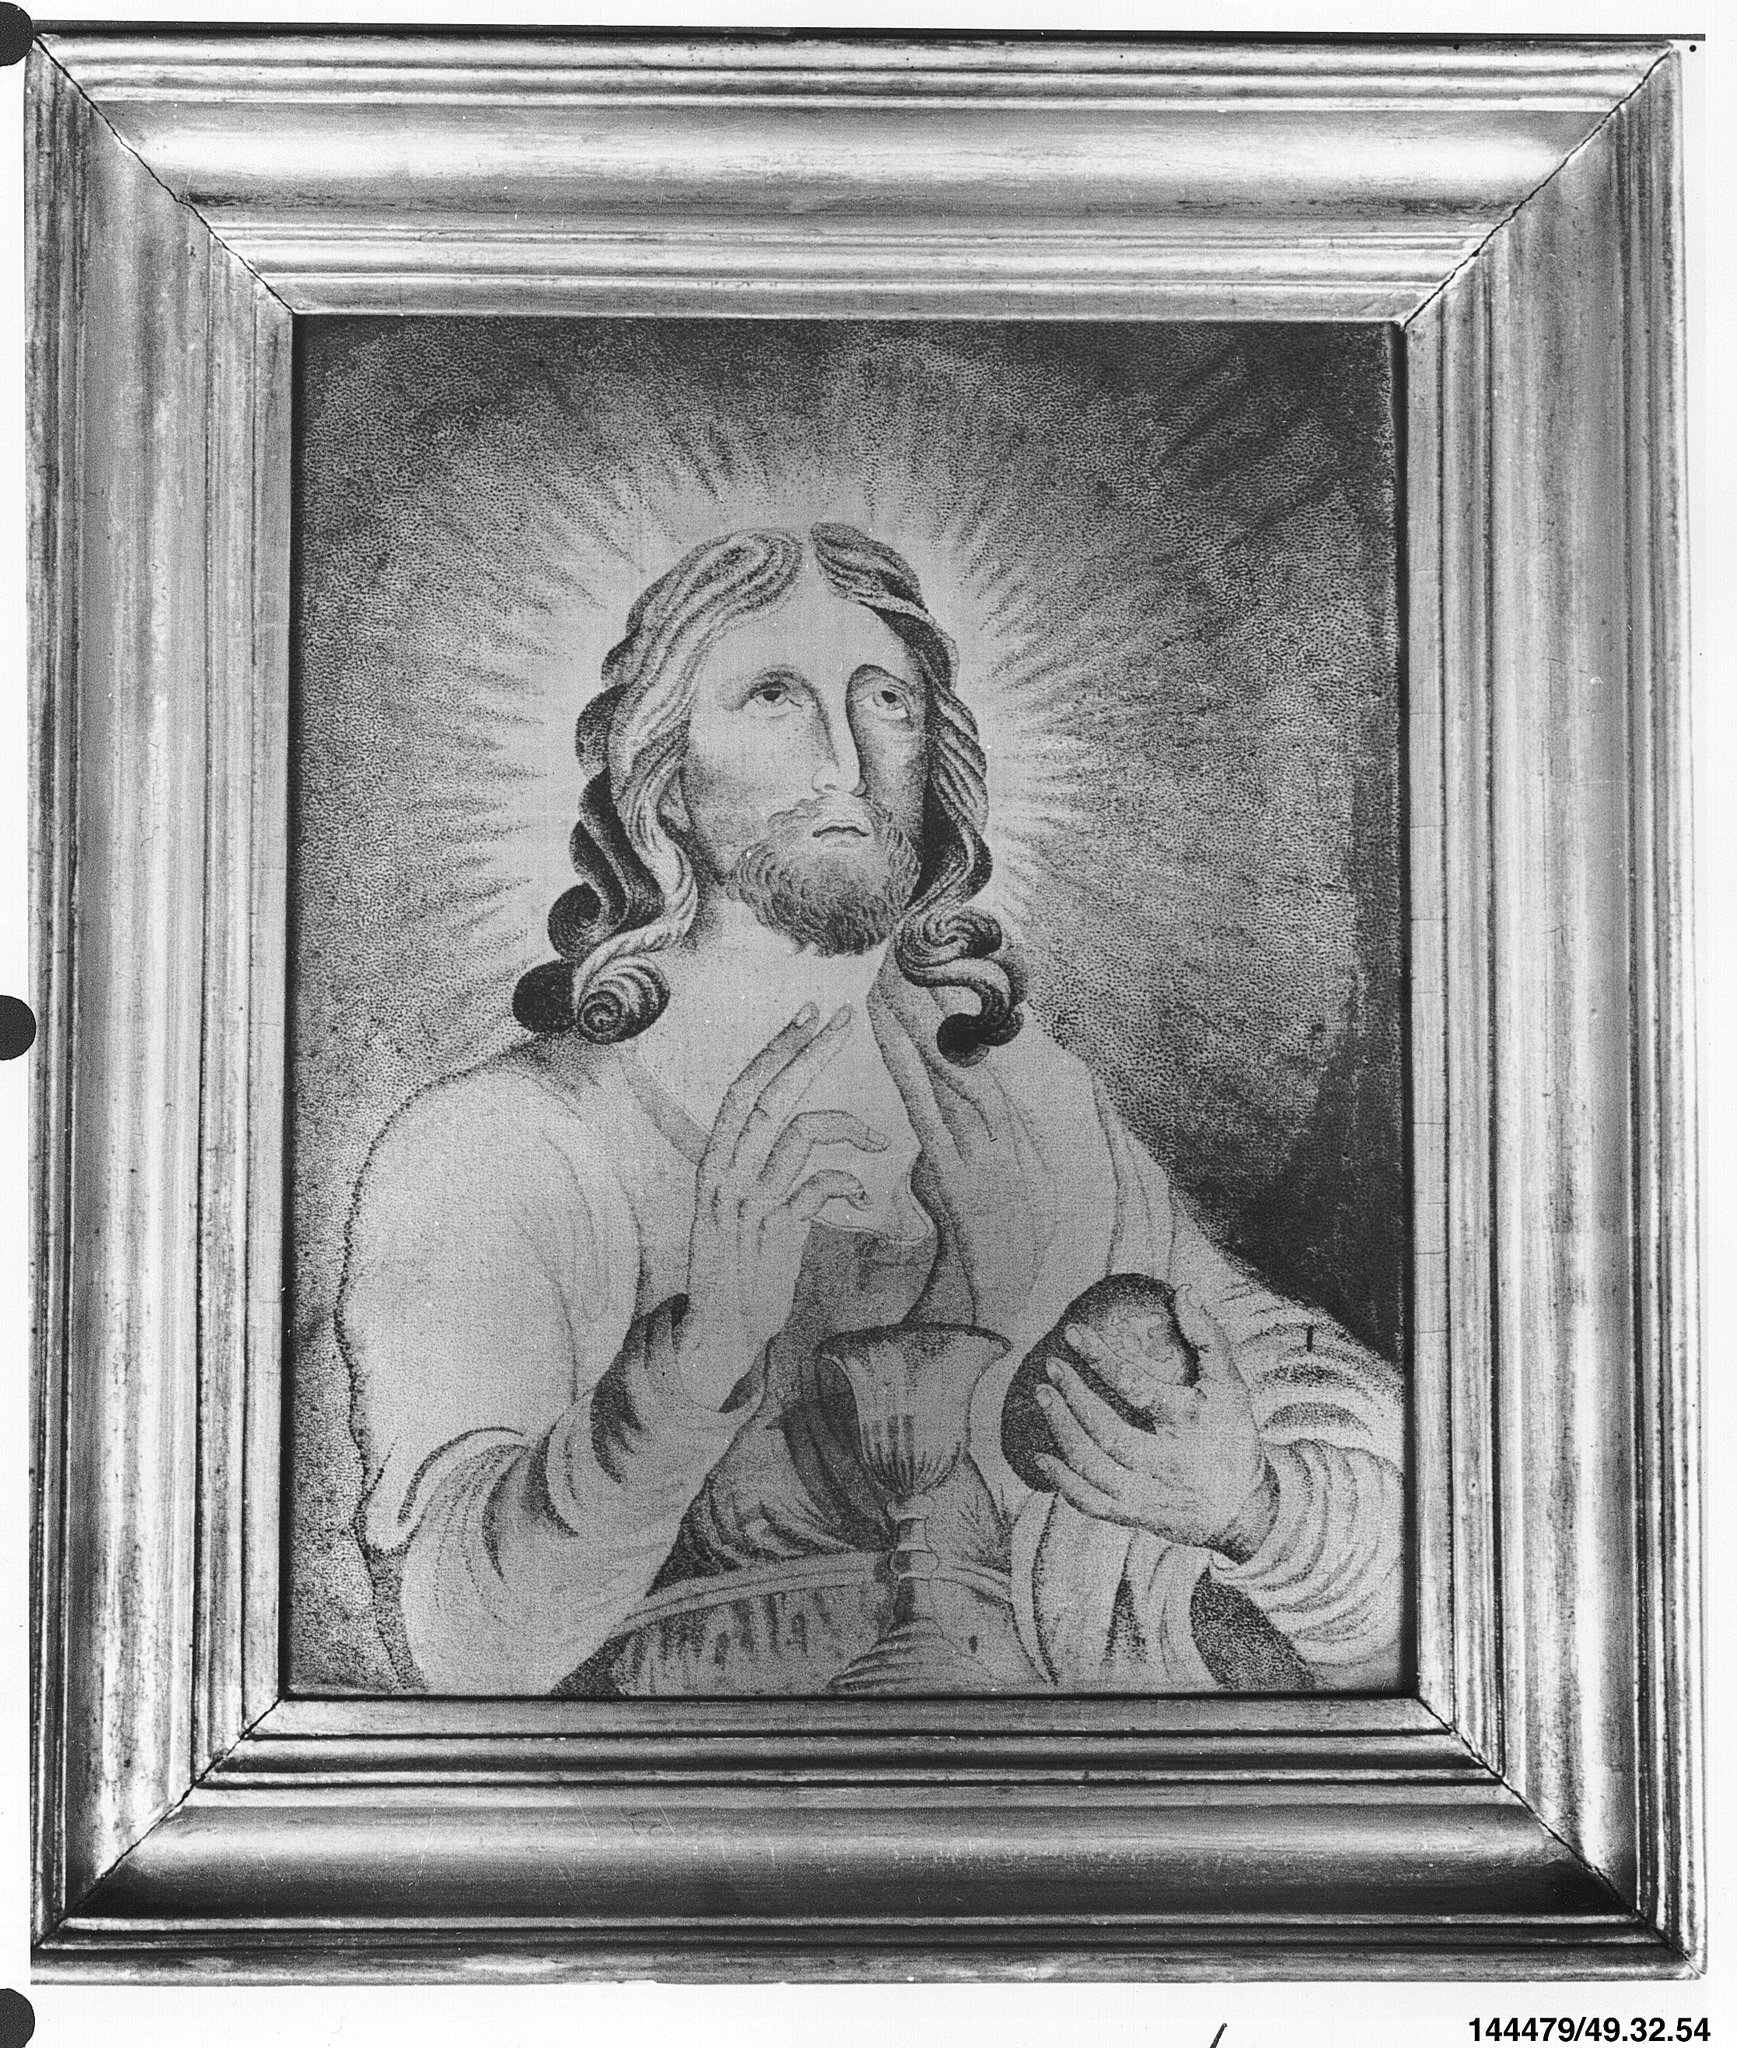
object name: embroidered picture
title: Jesus blessing the bread and wine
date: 1801-1850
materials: silk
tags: jesus